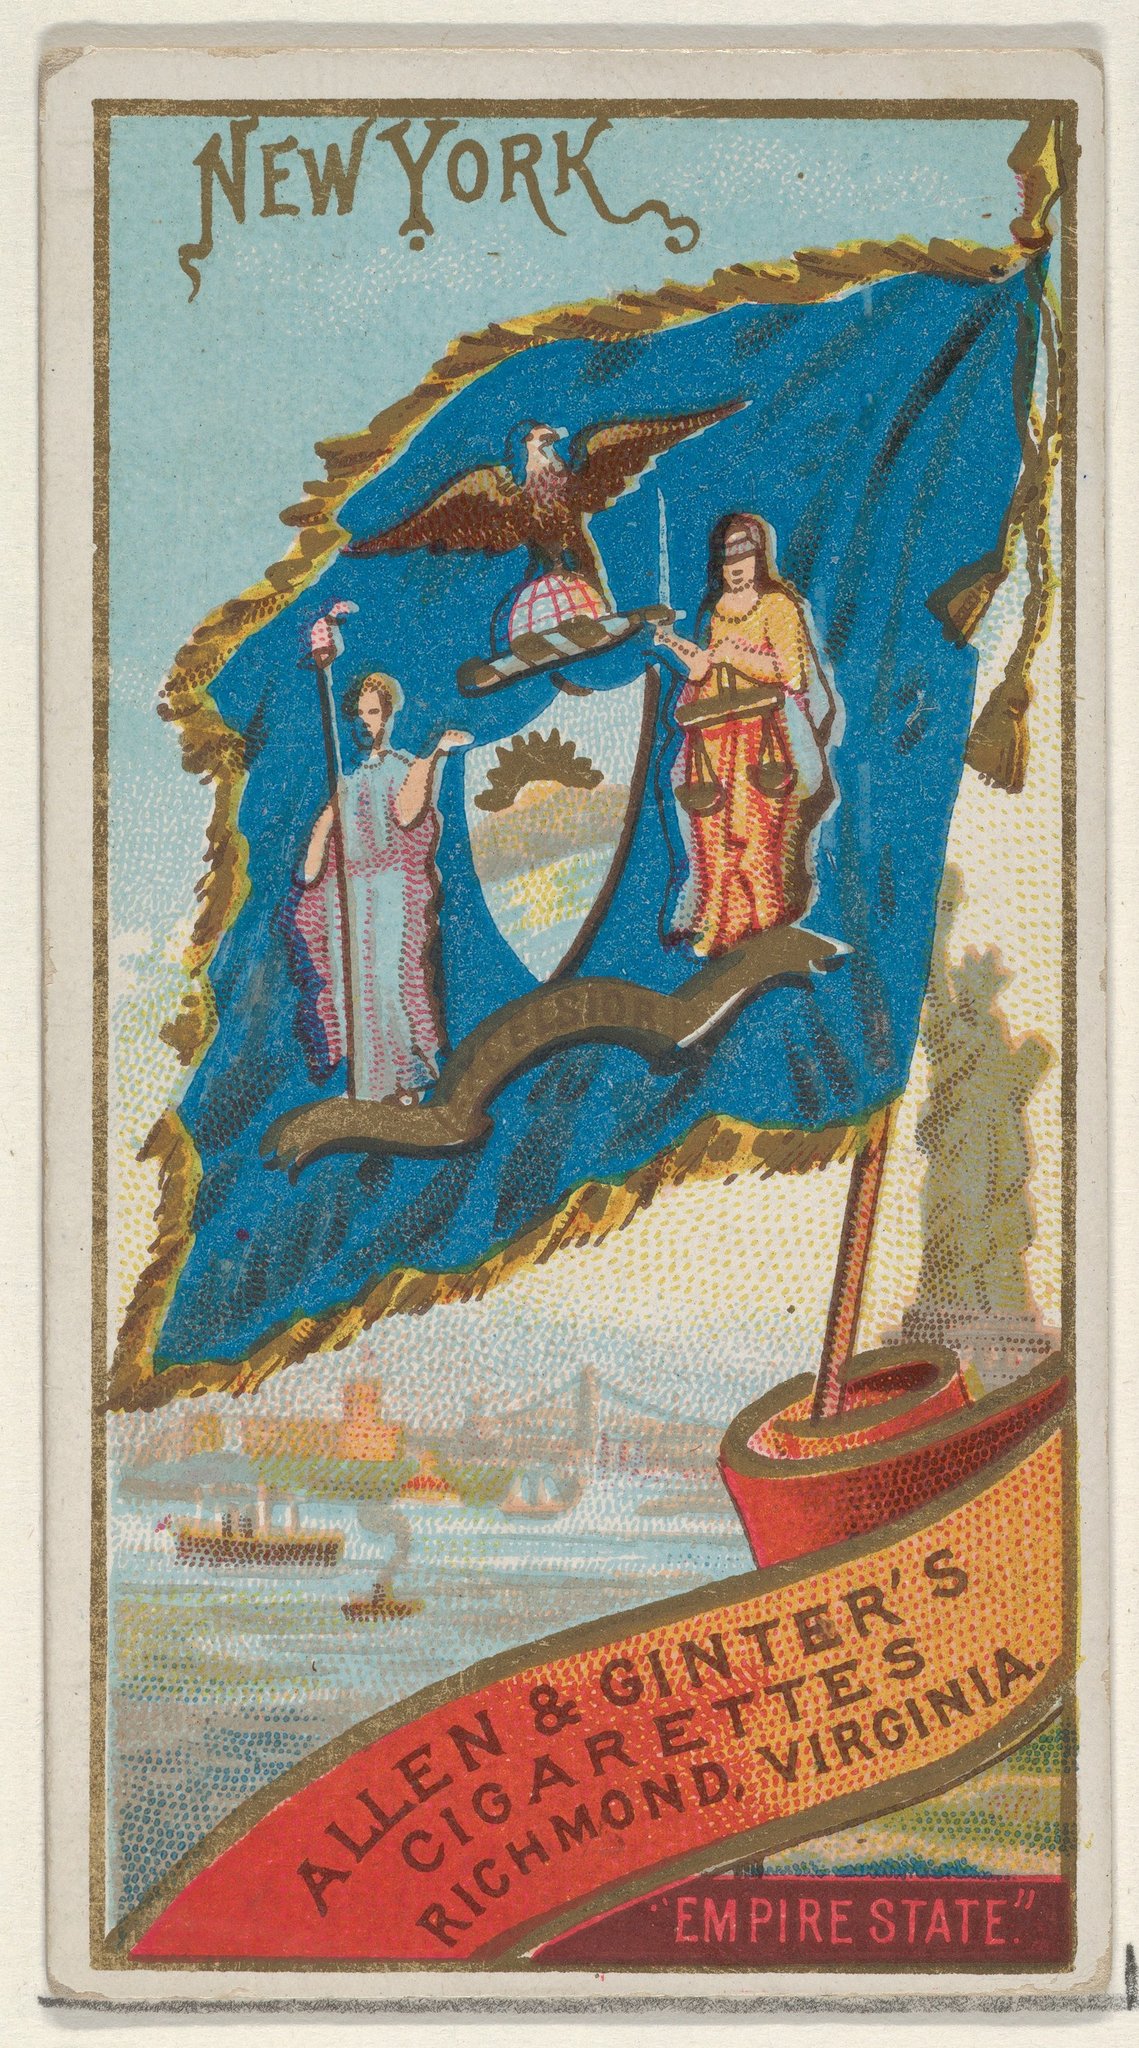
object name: print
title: New York, from Flags of the States and Territories (N11) for Allen & Ginter Cigarettes Brands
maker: allen & ginter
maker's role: publisher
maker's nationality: american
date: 1888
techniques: color lithograph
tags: coat of arms,flags